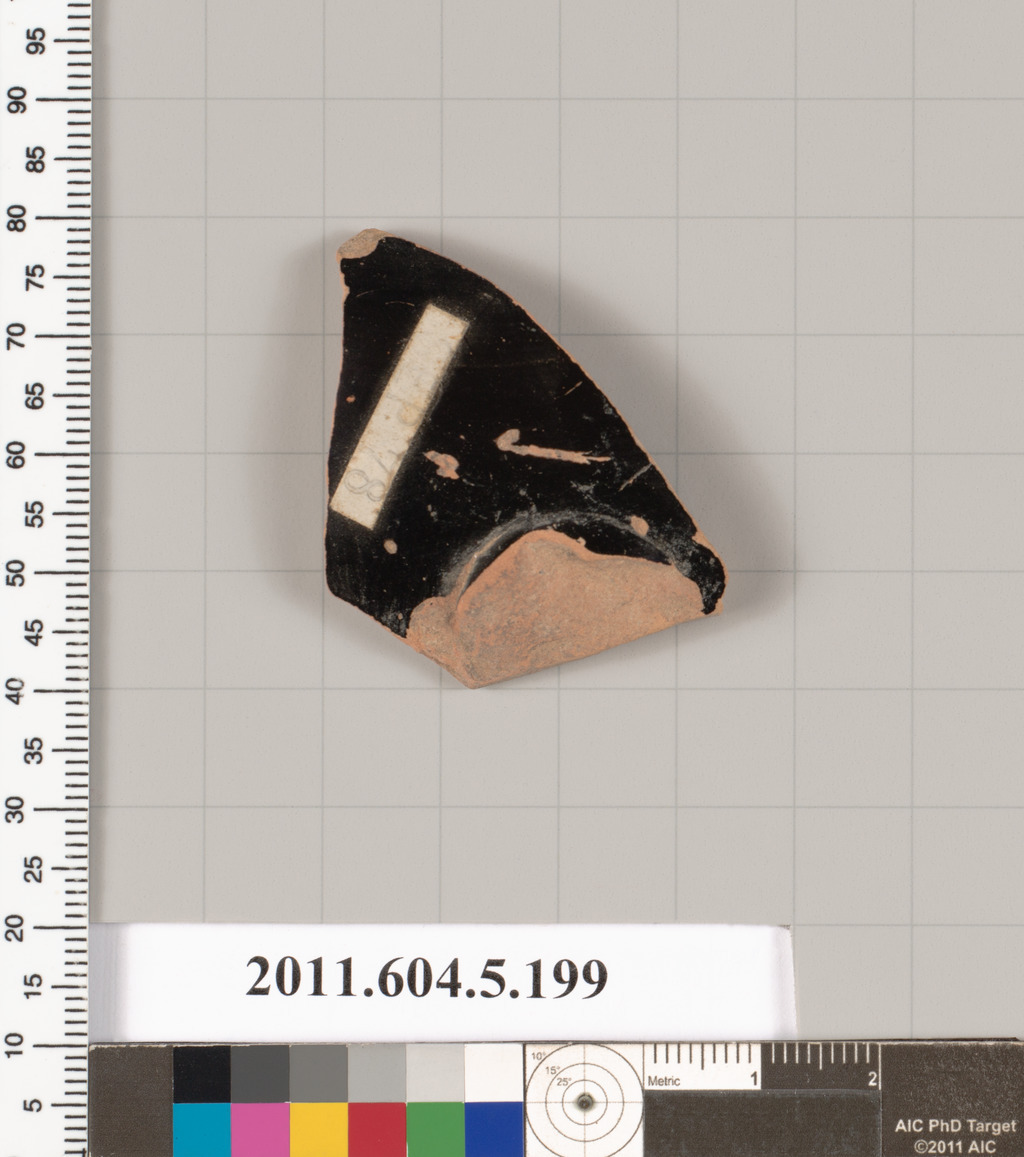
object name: kylix fragment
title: Terracotta fragment of a kylix (drinking cup)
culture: greek, attic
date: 600-401 BCE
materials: terracotta